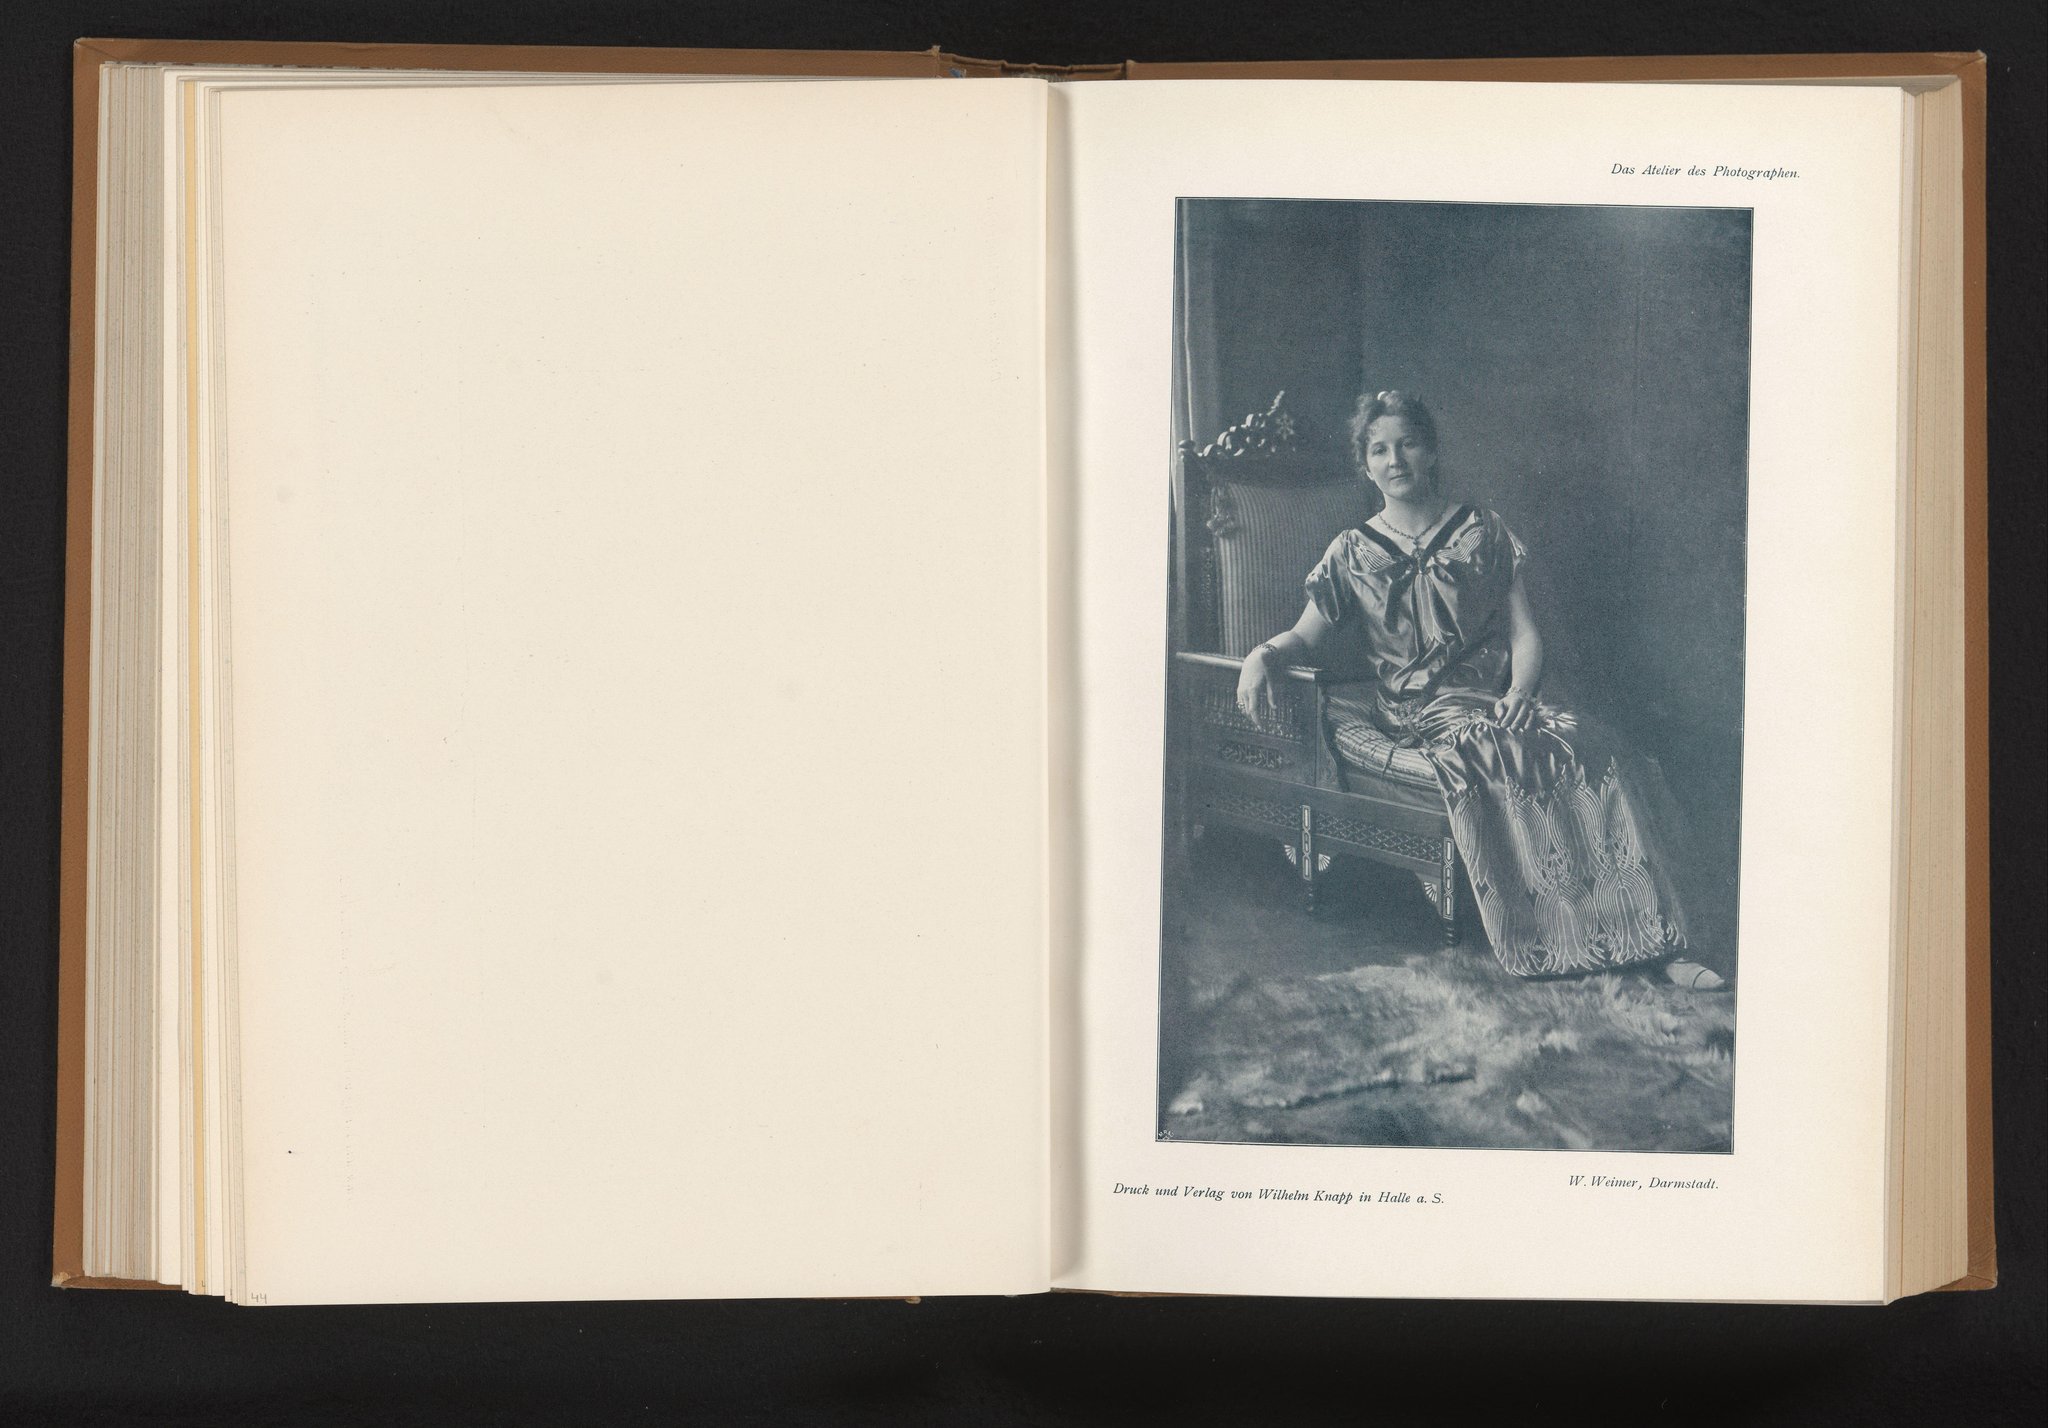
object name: photomechanical print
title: Portret van een onbekende vrouw in een fauteuil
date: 1895-1900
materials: paper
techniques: autotype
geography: halle an der saale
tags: historical persons - bb - woman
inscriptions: inscription: ‘Das Atelier des Photographen.’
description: Prent op derde ongenummerde pagina na pagina 176.